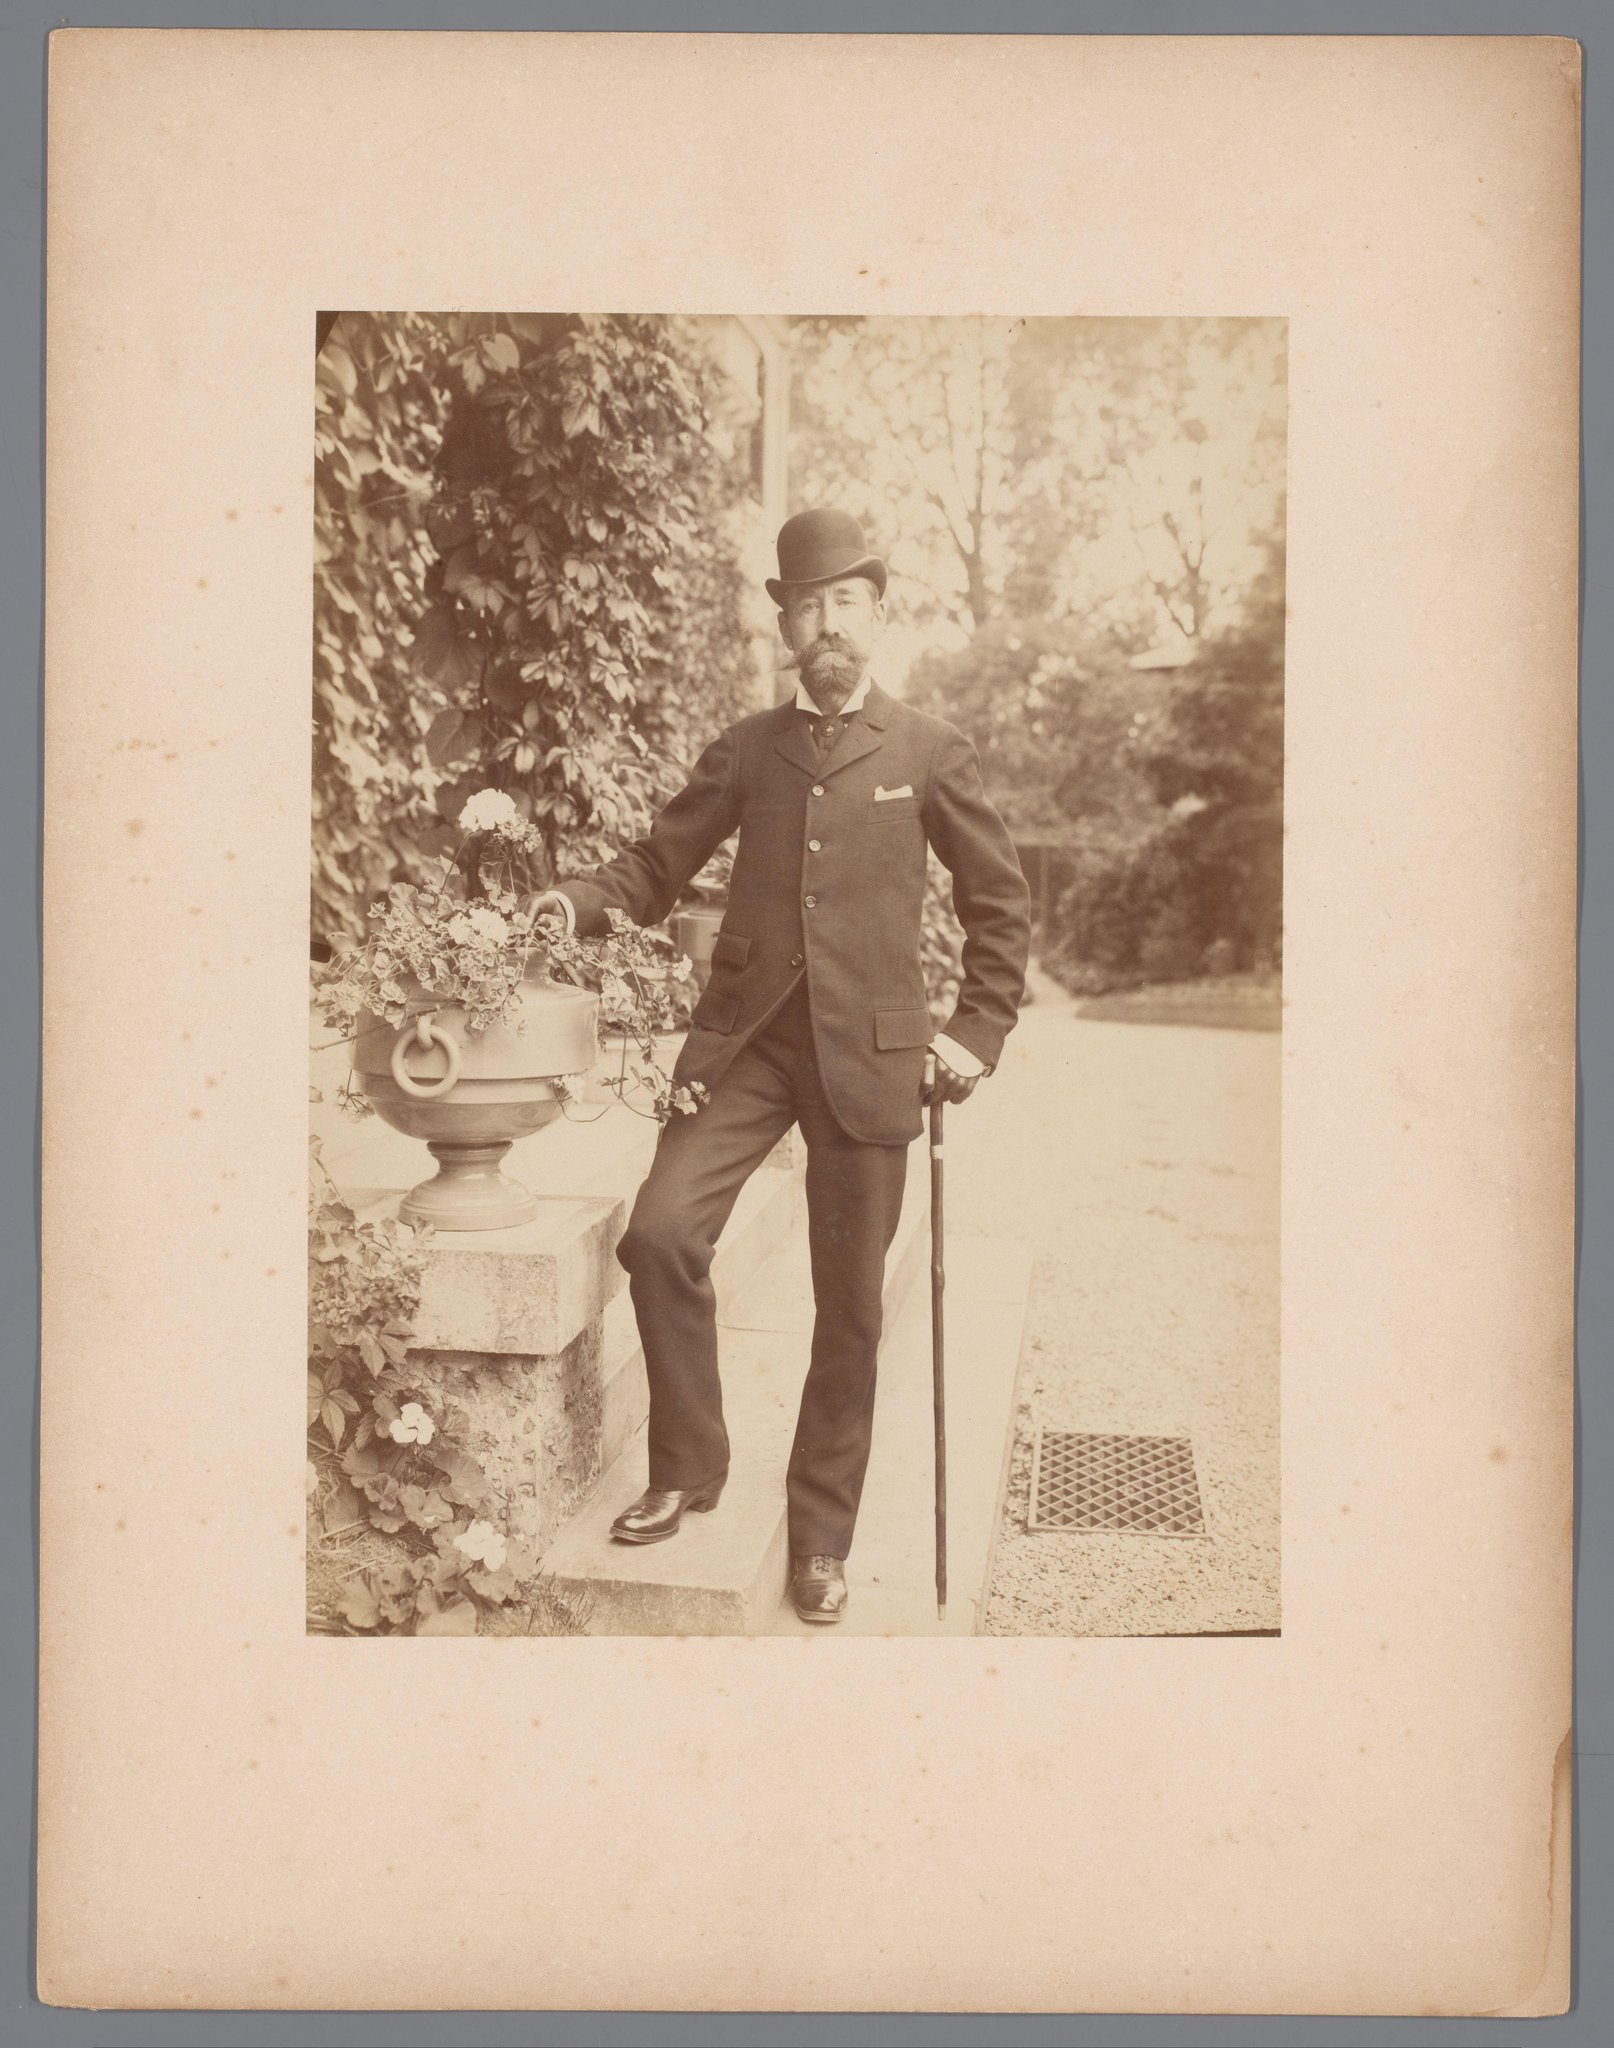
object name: photograph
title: Portret van een staande man in een tuin of park, met wandelstok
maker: Anonymous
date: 1880-1910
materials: cardboard, paper, photographic support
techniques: albumen print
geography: france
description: Portret van een staande man in een park of tuin. Hij is gekleed in een zwart pak, heeft een wandelstok in zijn linkerhand.